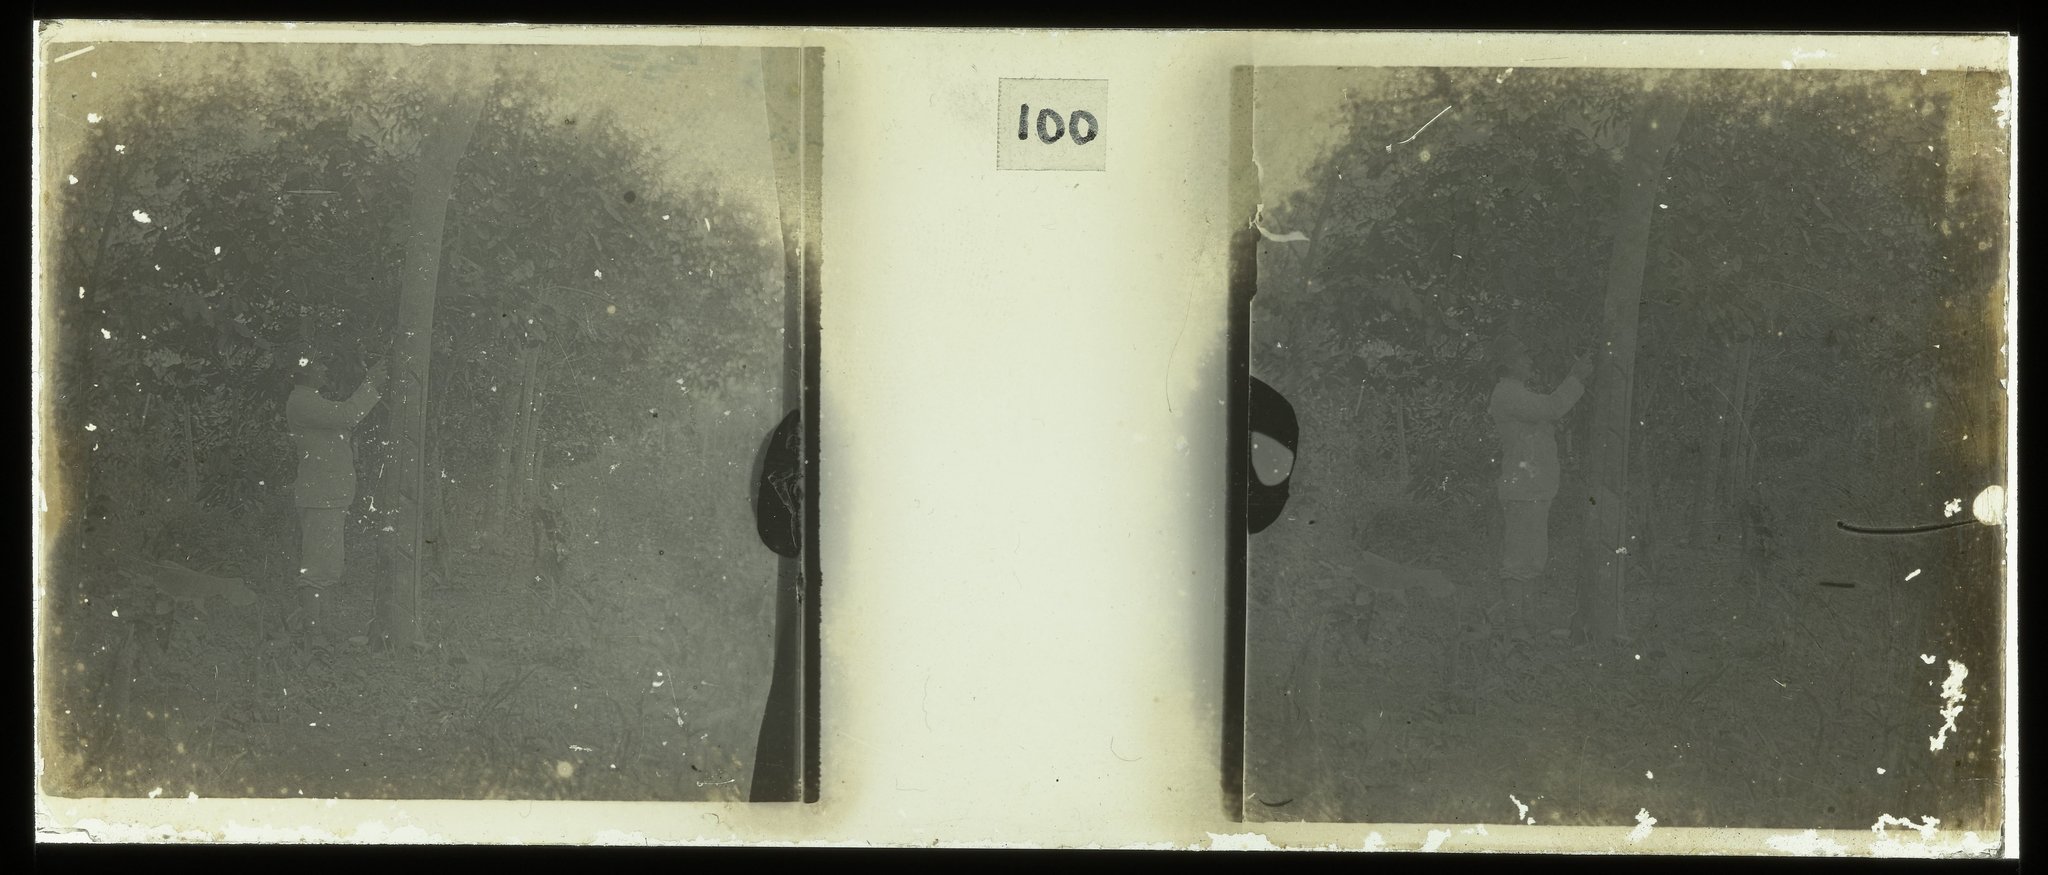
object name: stereograph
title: Plantage met gewas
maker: theodoor brouwers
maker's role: amateurfotograaf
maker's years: 1874-1932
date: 1913-1930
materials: glass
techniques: photography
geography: suriname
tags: amsterdam, theodoor brouwers, suriname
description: In de periode 1911-1932 woonde op plantage Accaribo in Suriname de familie Brouwers van wie de foto's afkomstig zijn. Rond 1910 vond Theodoor Brouwers werk op plantage Accaribo. In 1929 werd hij eigenaar van de plantage. Op Accaribo werden in zijn tijd bananen geproduceerd en wat koffie.